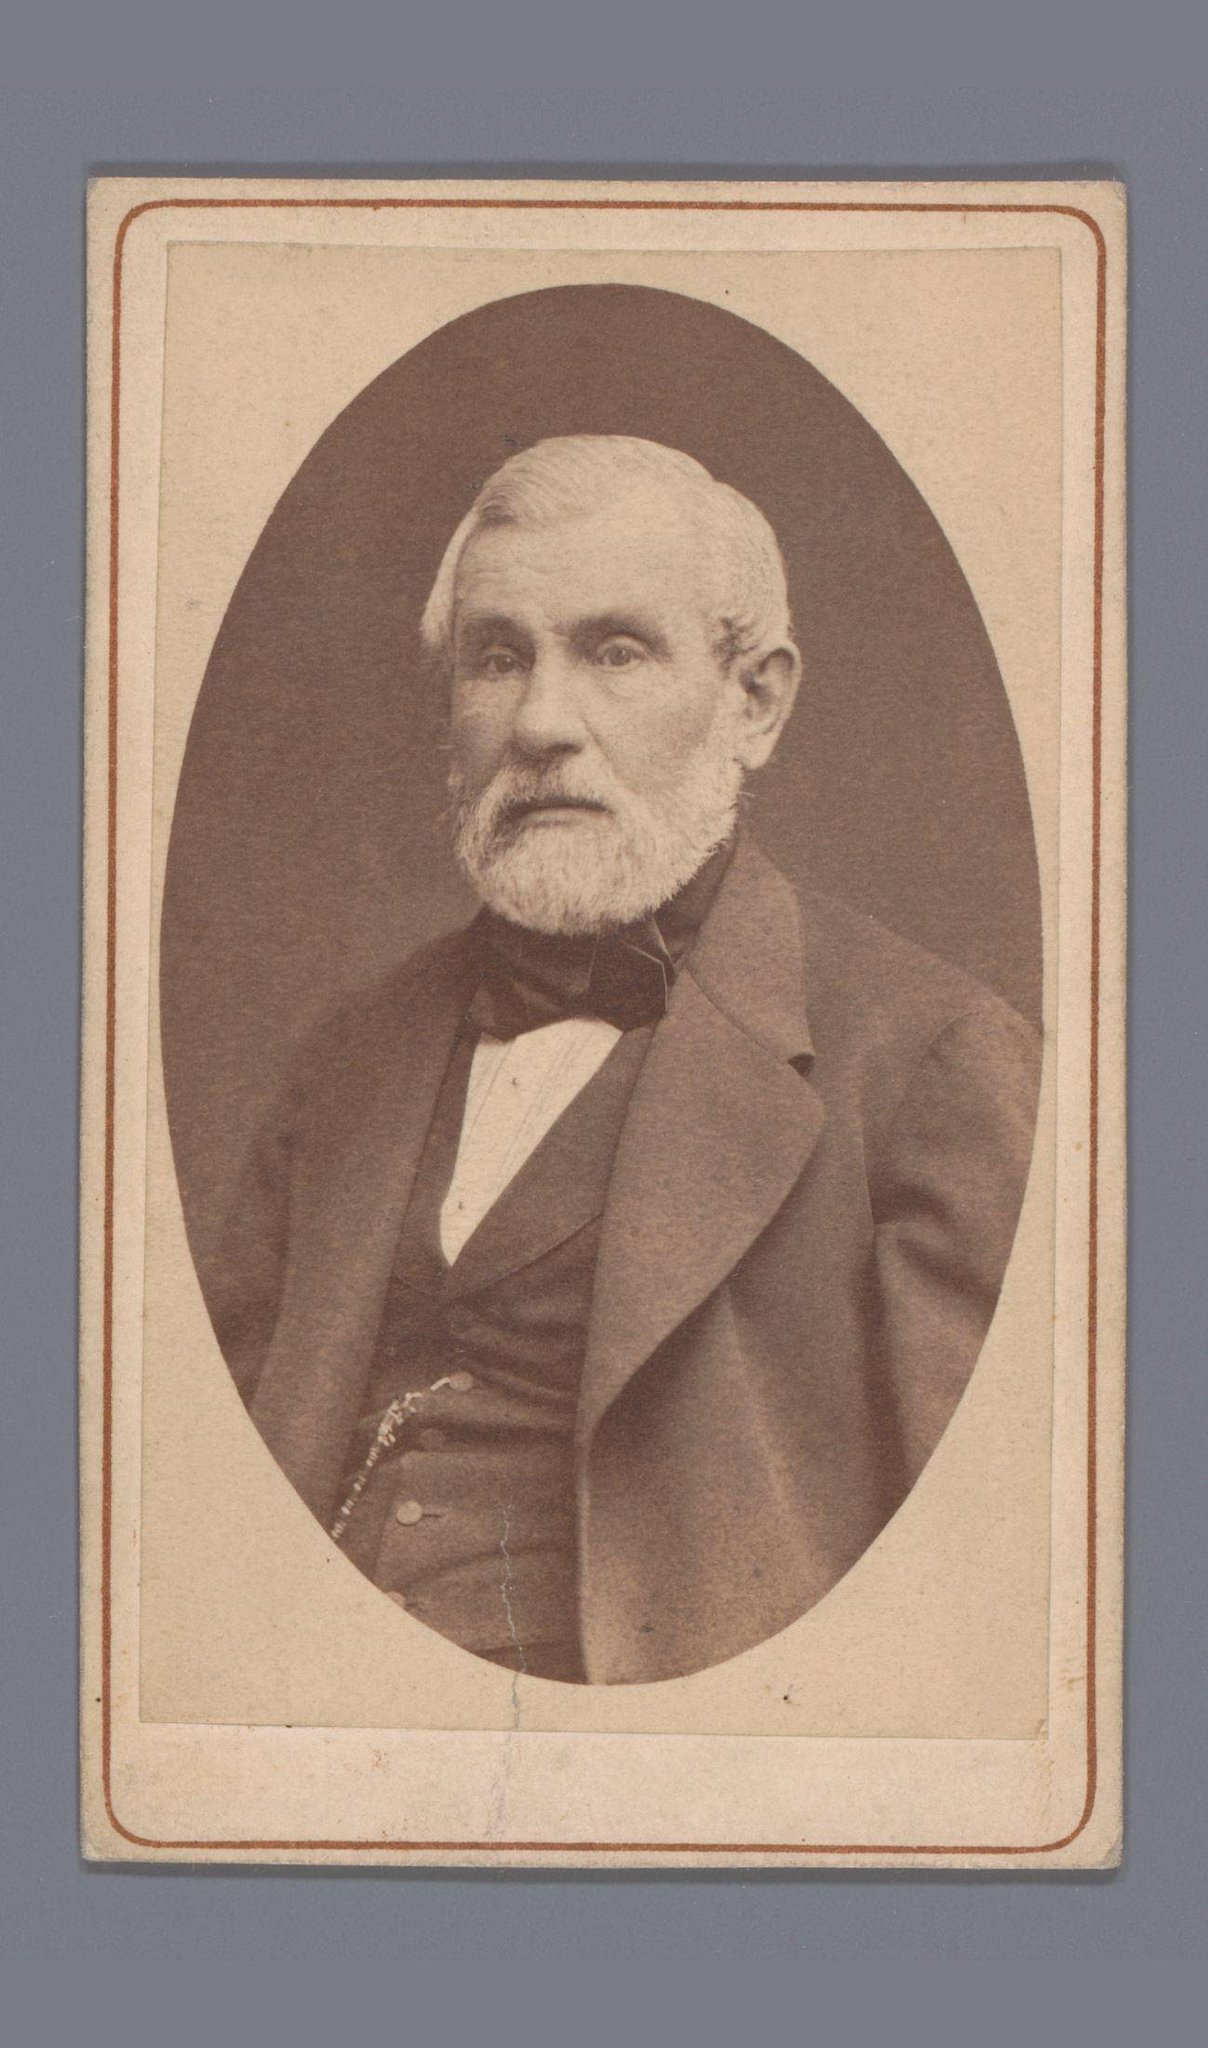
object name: photograph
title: Portret van een onbekende man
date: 1867-1880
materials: cardboard, paper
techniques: albumen print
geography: stockholm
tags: old man, historical persons not known by name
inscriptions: inscription: ‘[...]’, address: ‘HOF-PHOTOGRAFER/ STOCKHOLM/ Regeringsgatan No. 18.’, inscription: ‘Originalplåten bevaras för vidare/ beställning.’